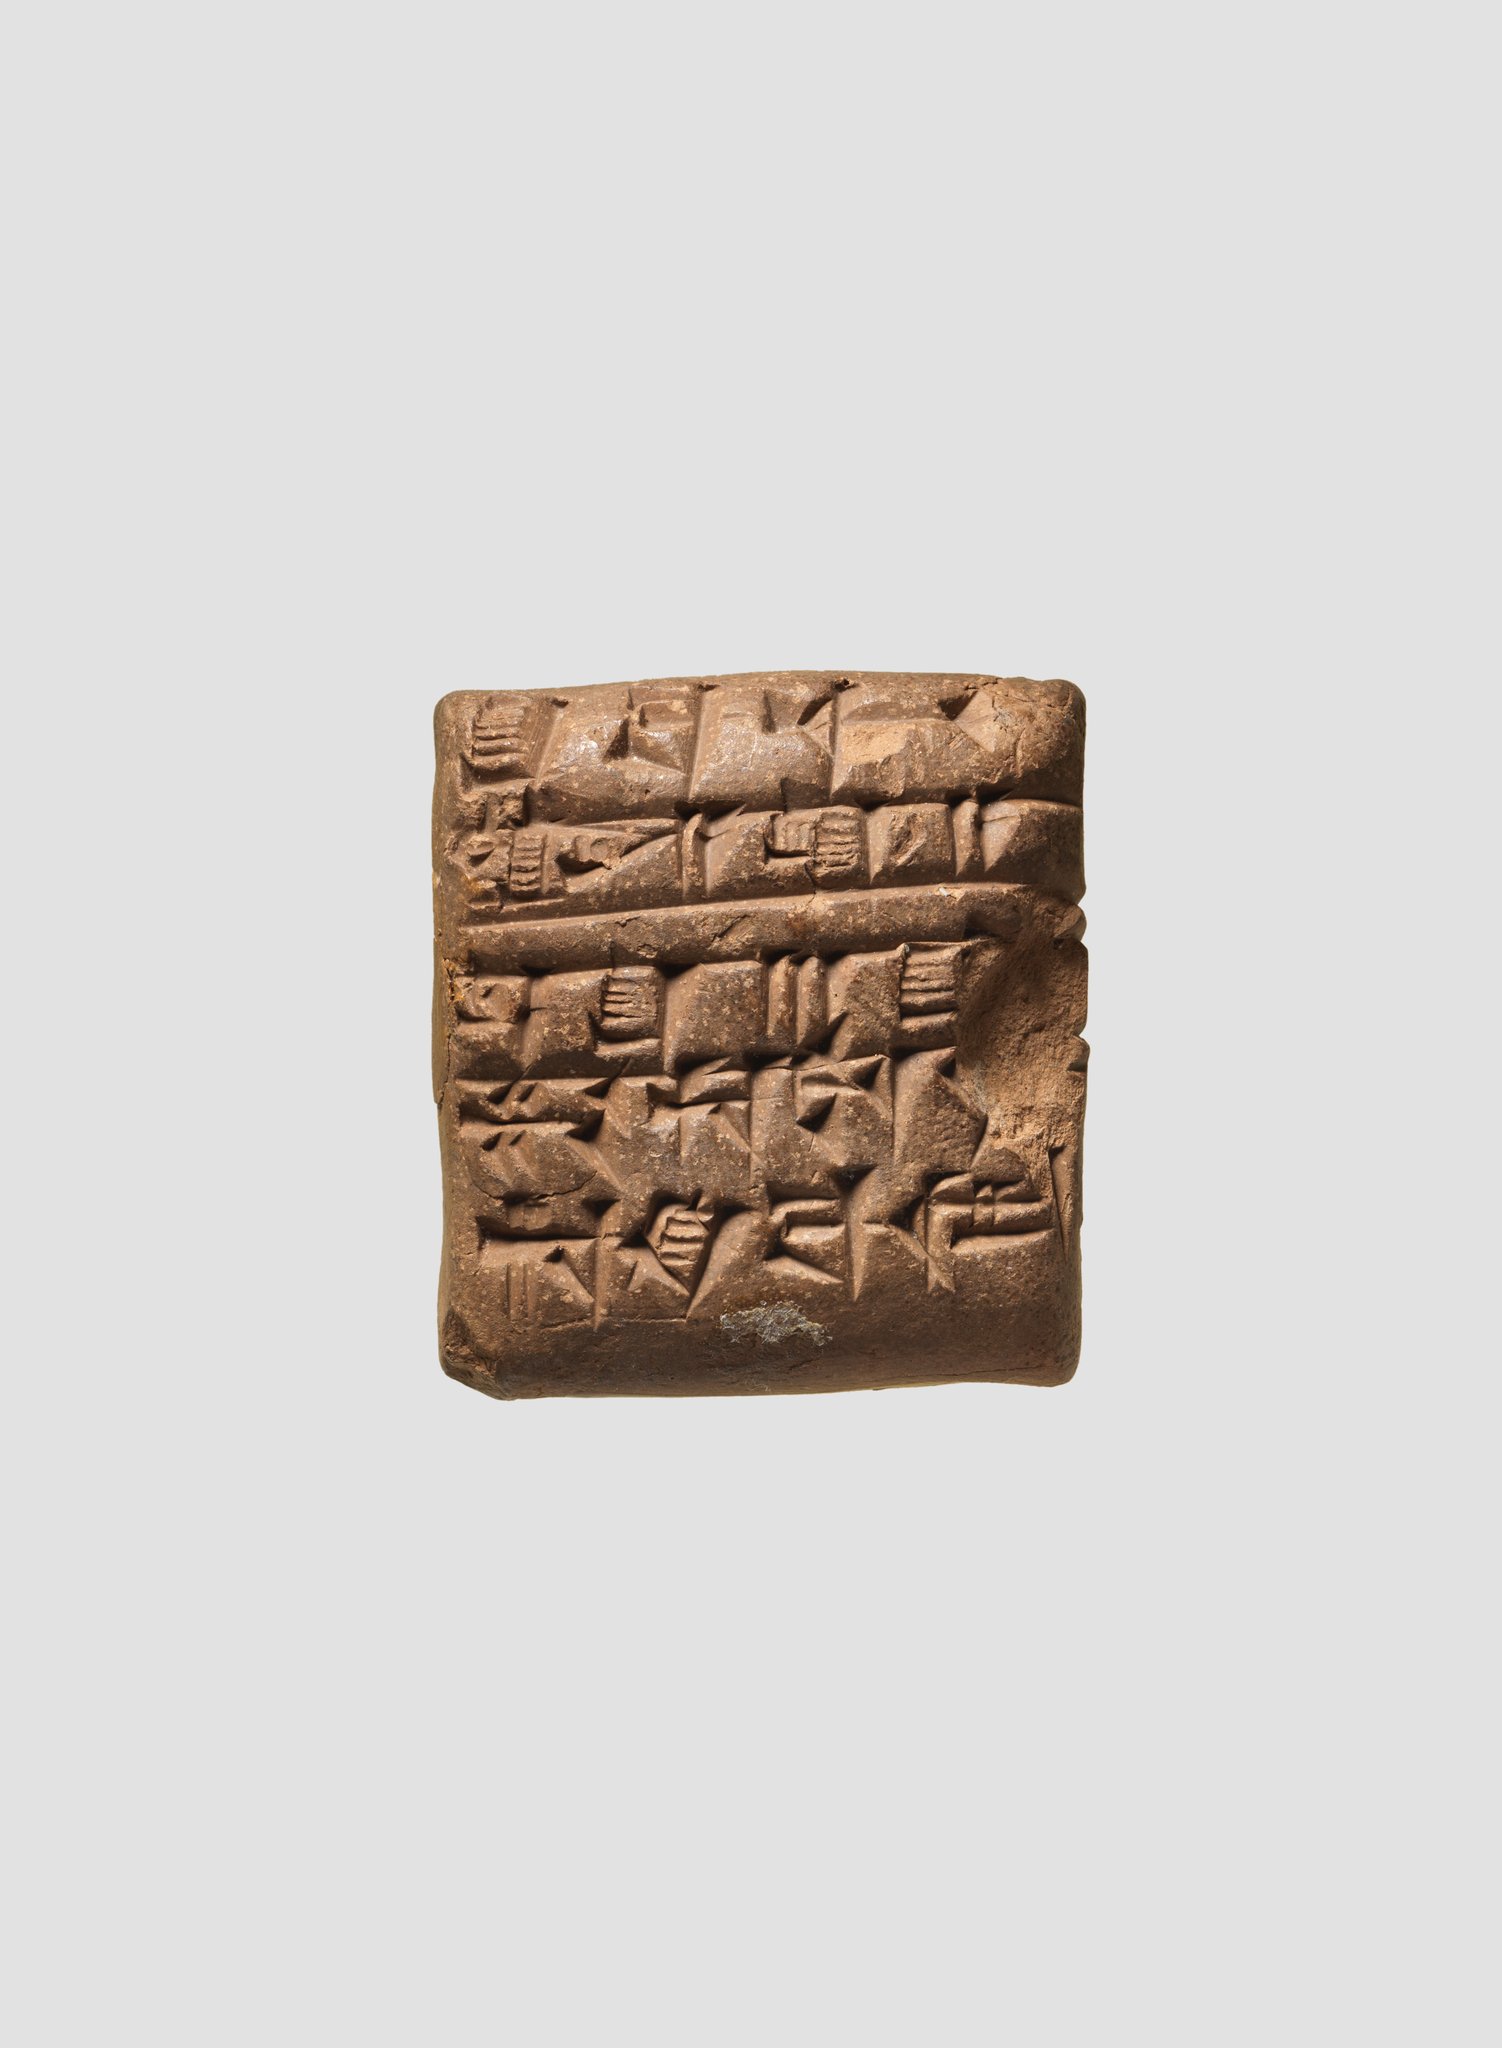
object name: cuneiform tablet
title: Cuneiform tablet: receipt of straw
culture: neo-sumerian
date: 2040 BCE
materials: clay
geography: mesopotamia